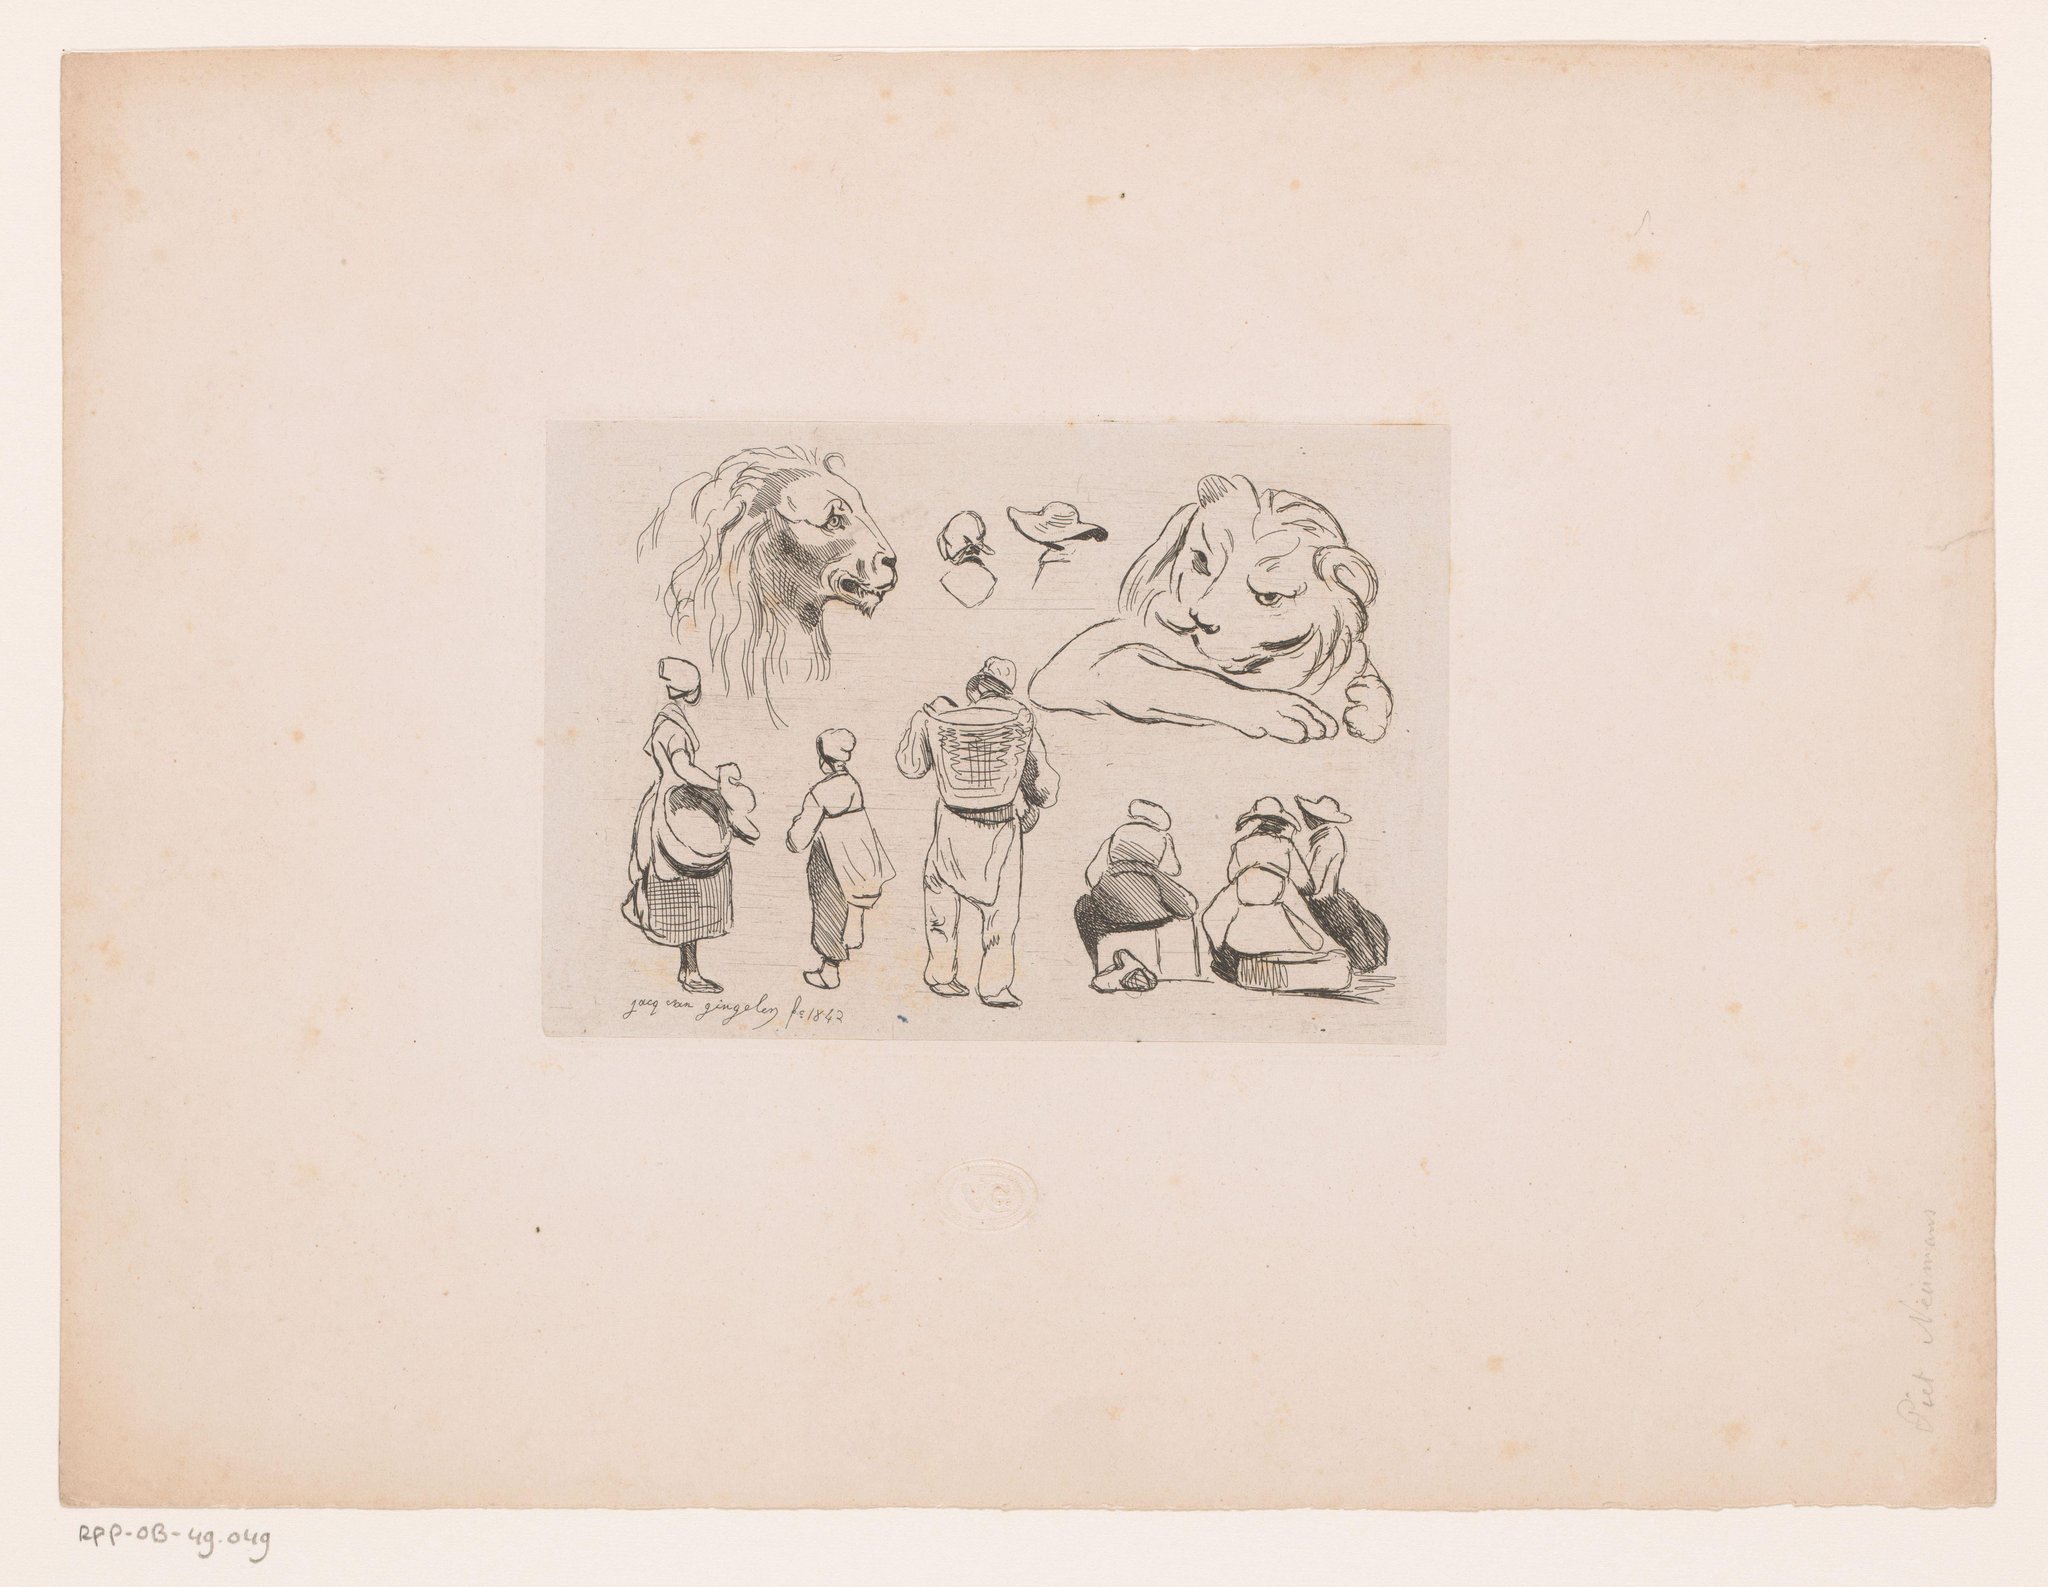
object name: print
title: Studie van figuren en twee leeuwenkoppen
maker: jacques van gingelen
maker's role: print maker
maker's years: 1801-1864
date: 1842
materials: paper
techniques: etching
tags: postures of the human figure, beasts of prey, predatory animals: lion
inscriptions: collector's mark: Lugt 2228, mark: ‘JVG’